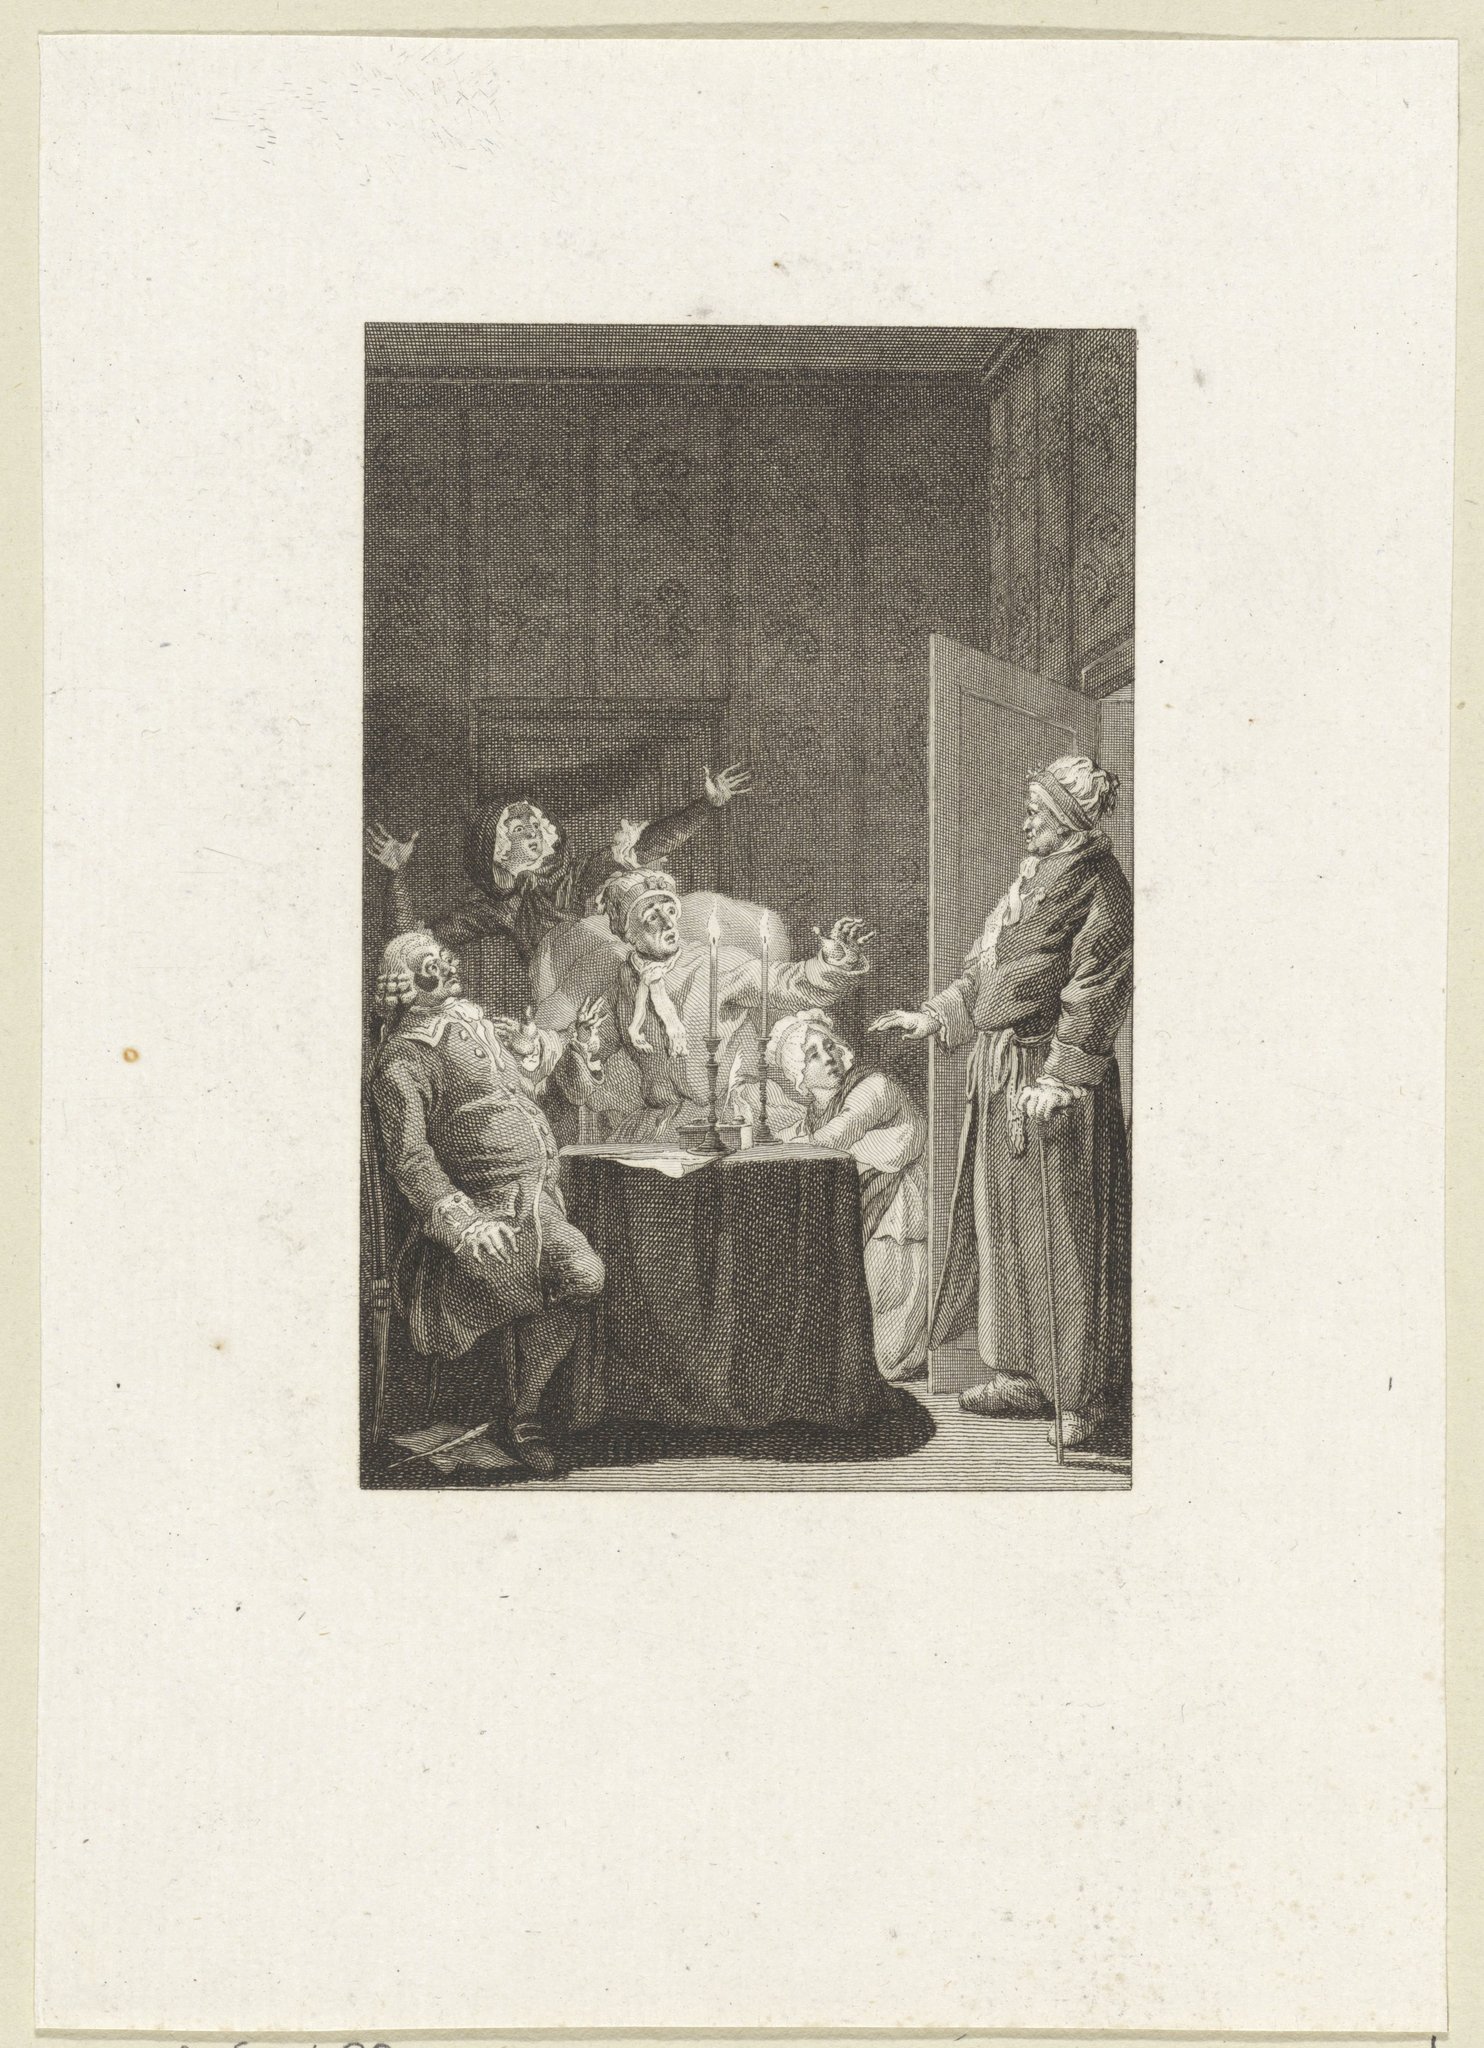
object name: print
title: Dood gewaande man stapt een vertrek binnen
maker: reinier vinkeles (i)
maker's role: draughtsman, print maker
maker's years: 1741-1816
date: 1791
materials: paper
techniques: engraving, etching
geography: amsterdam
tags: visiting; receiving guests; elegant company, candle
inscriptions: collector's mark: Lugt 240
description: Proefdruk van een prent die mogelijk ook gebruikt is als illustratie in: Gotter, Friedrich Wilhelm. Het mislukt bedrog. Tooneelspel in 5 bedryven. Amsterdam: erven van Pieter Meĳer en Gerrit Warnars, 1791.